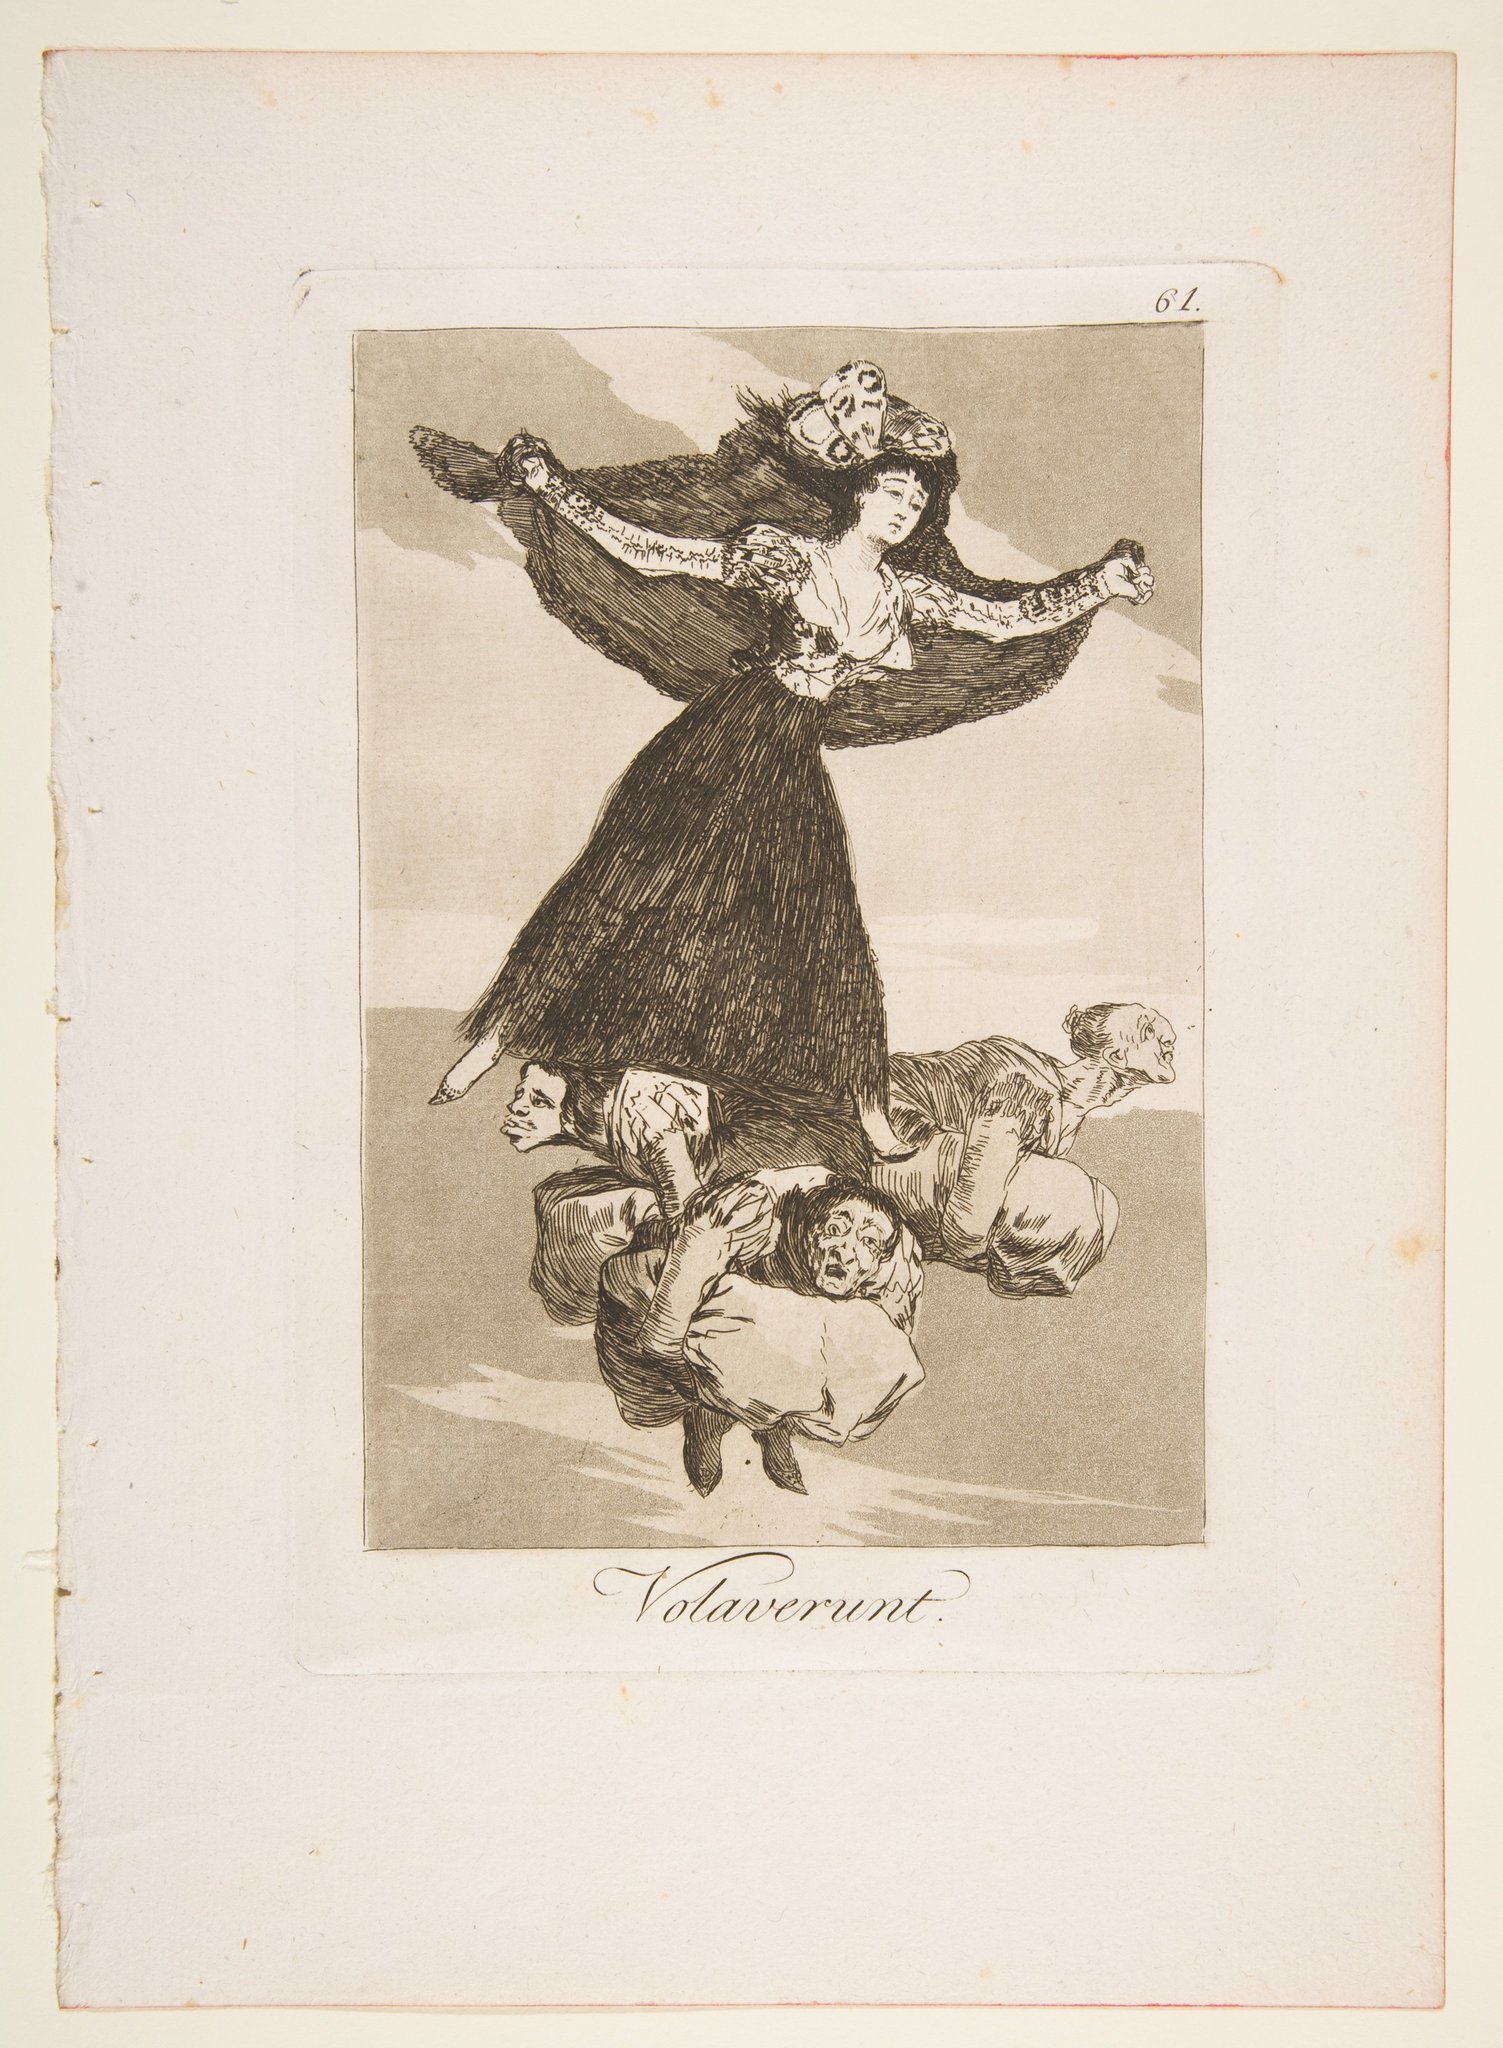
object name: print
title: Plate 61 from "Los Caprichos": They have flown (Volaverunt)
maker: goya (francisco de goya y lucientes)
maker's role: artist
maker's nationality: spanish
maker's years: 1746-1828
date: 1799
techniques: aquatint, drypoint, etching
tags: women